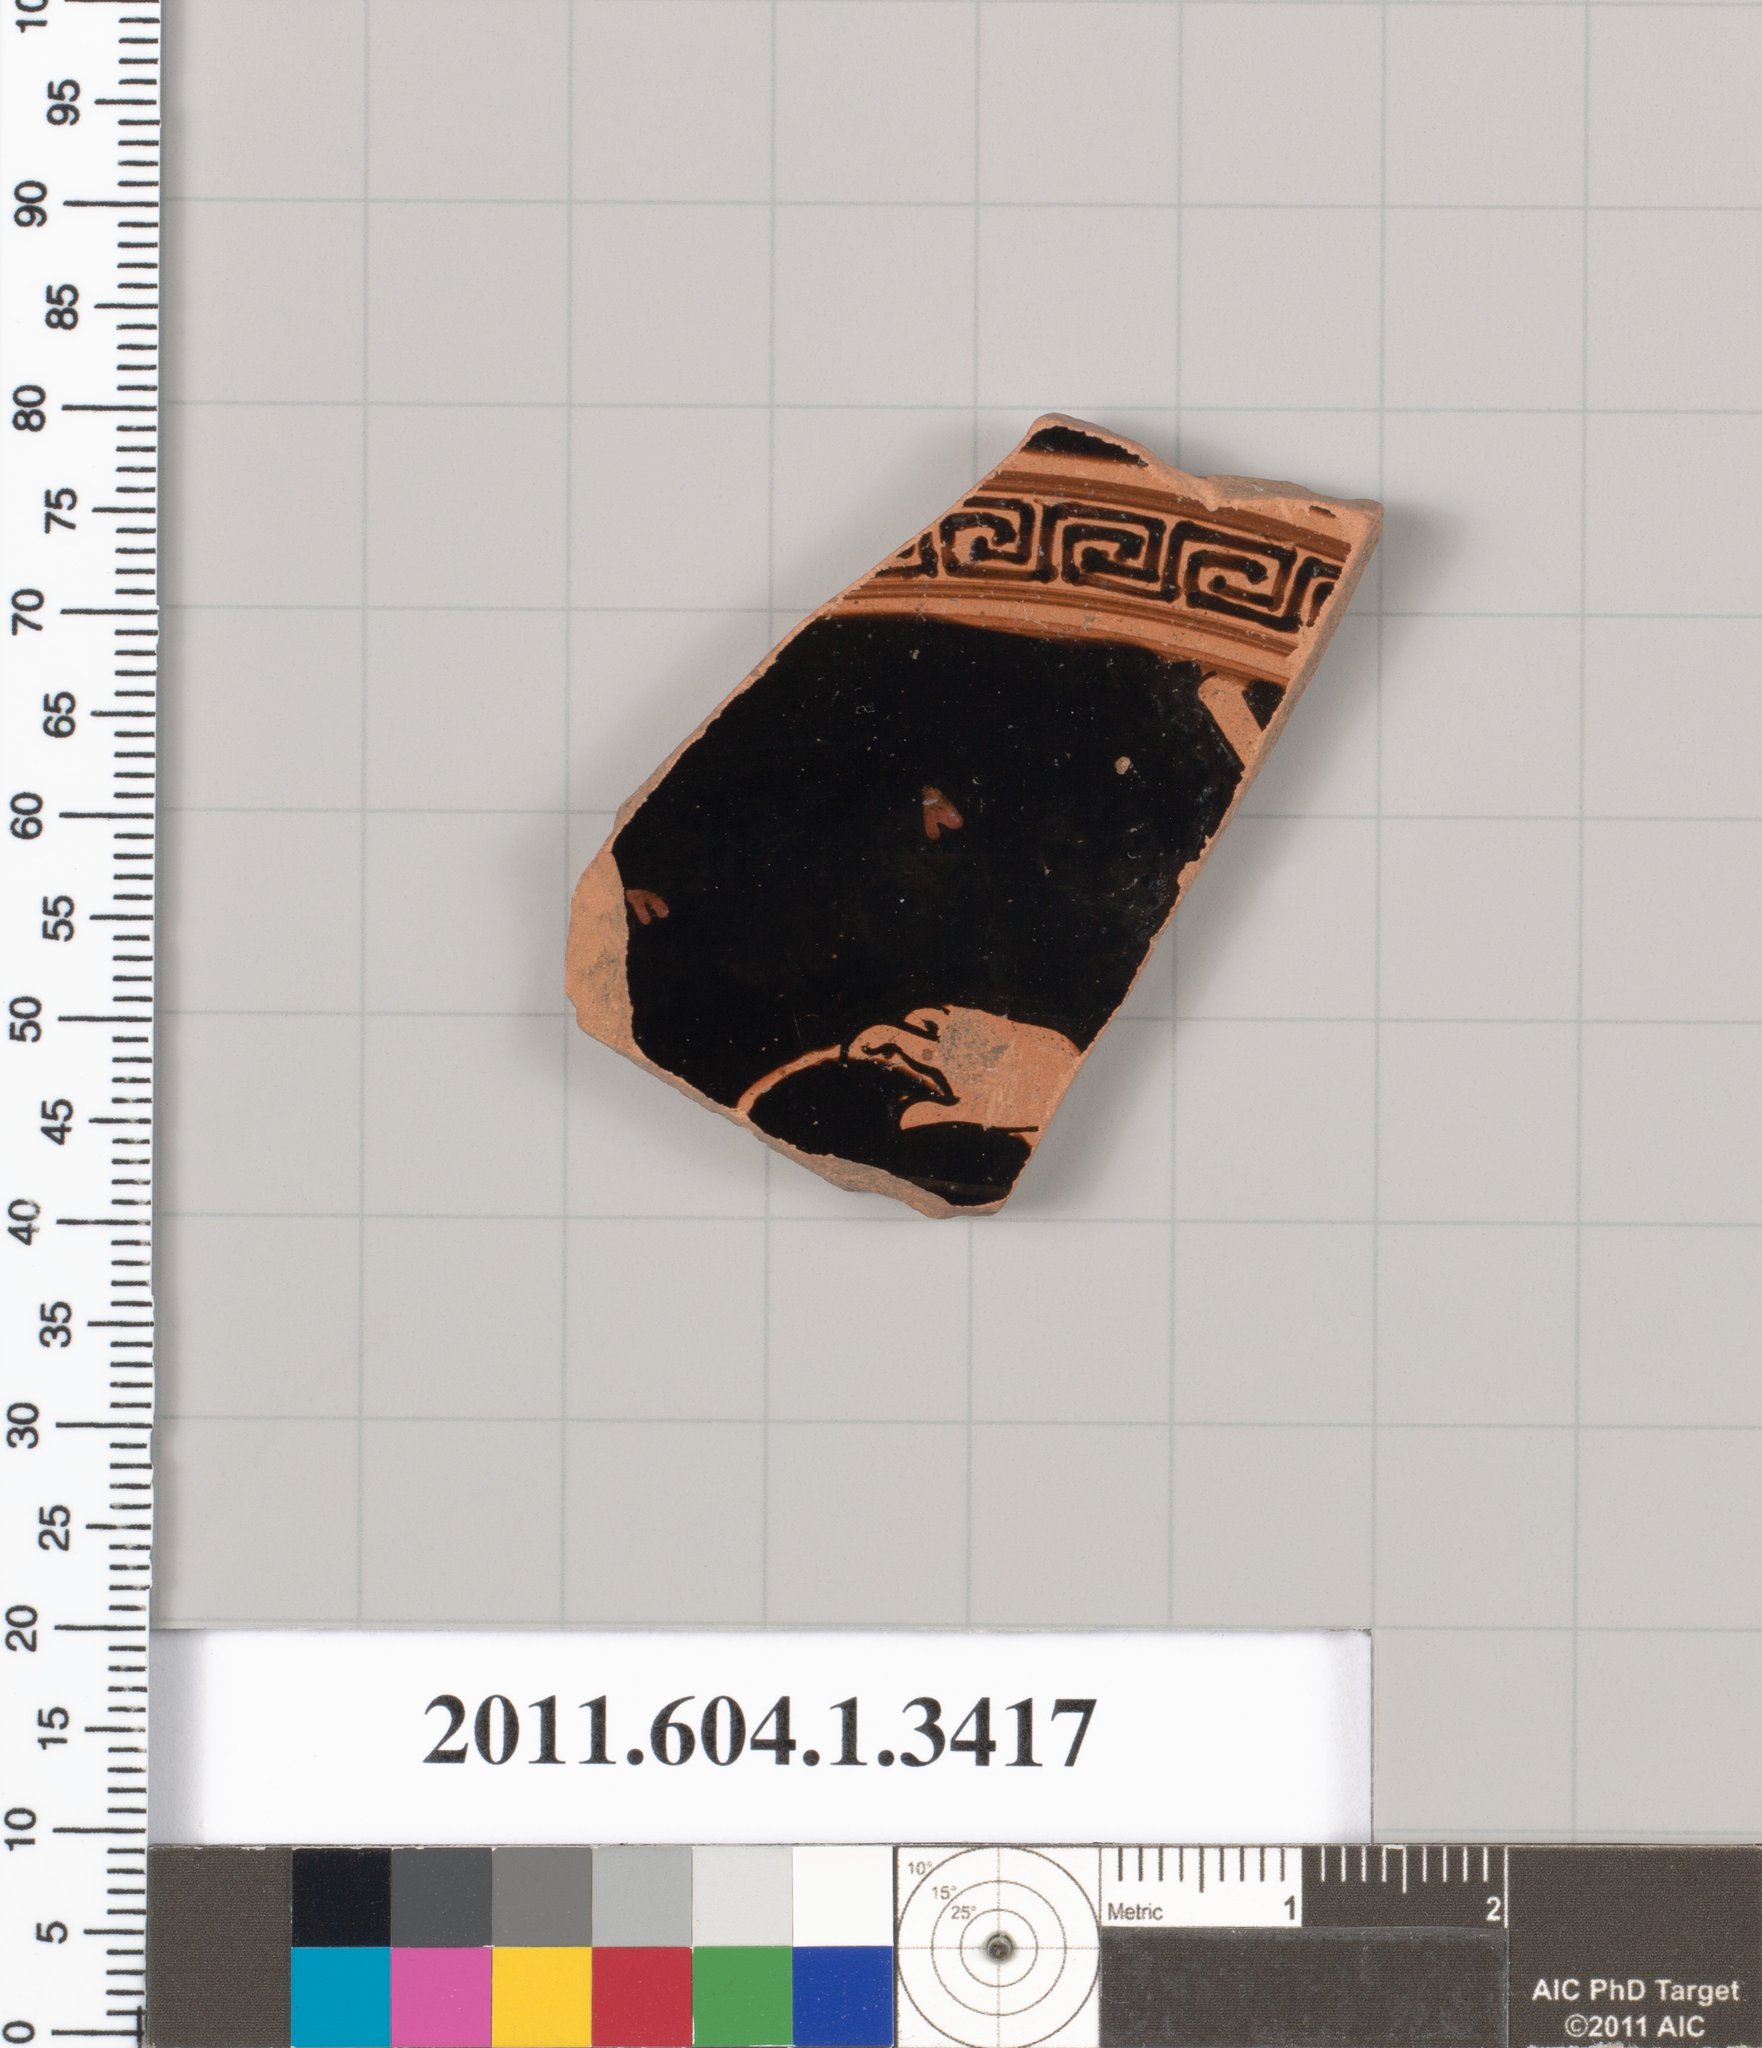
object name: kylix fragment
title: Terracotta fragment of a kylix (drinking cup)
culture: greek, attic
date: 490-470 BCE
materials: terracotta